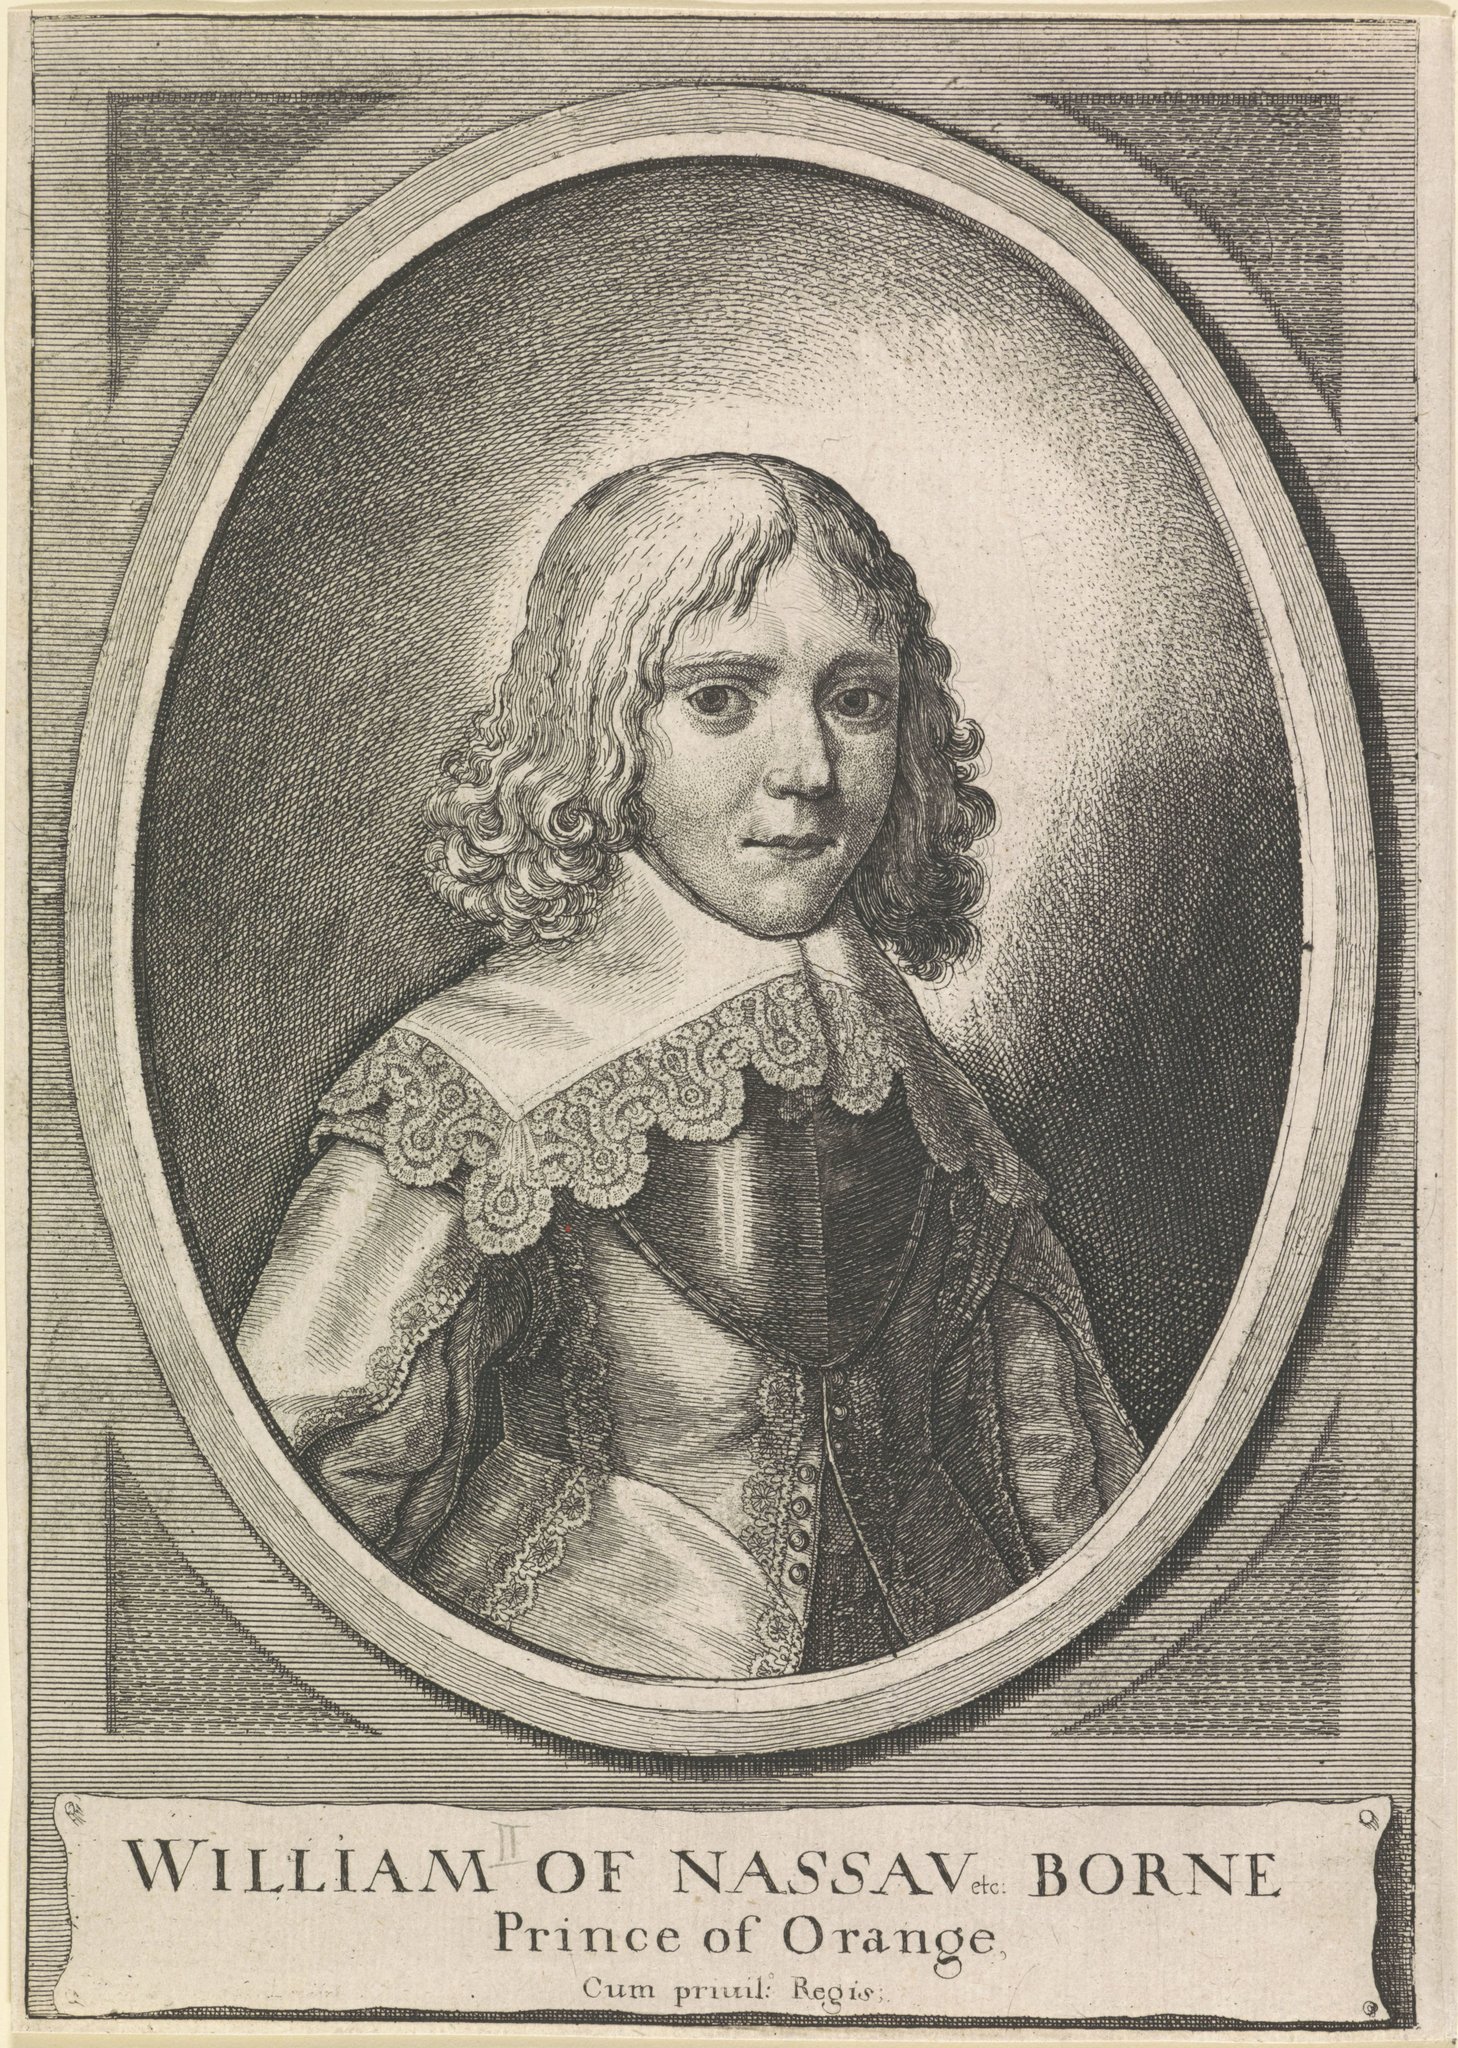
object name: print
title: Portret van Willem II, prins van Oranje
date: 1640-1667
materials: paper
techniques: engraving, etching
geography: london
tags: william ii (prince of orange)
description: De hier vermelde titel verwijst naar de hoogst verkregen titel van de geportretteerde, niet per se naar de titel die de geportretteerde op deze voorstelling draagt.